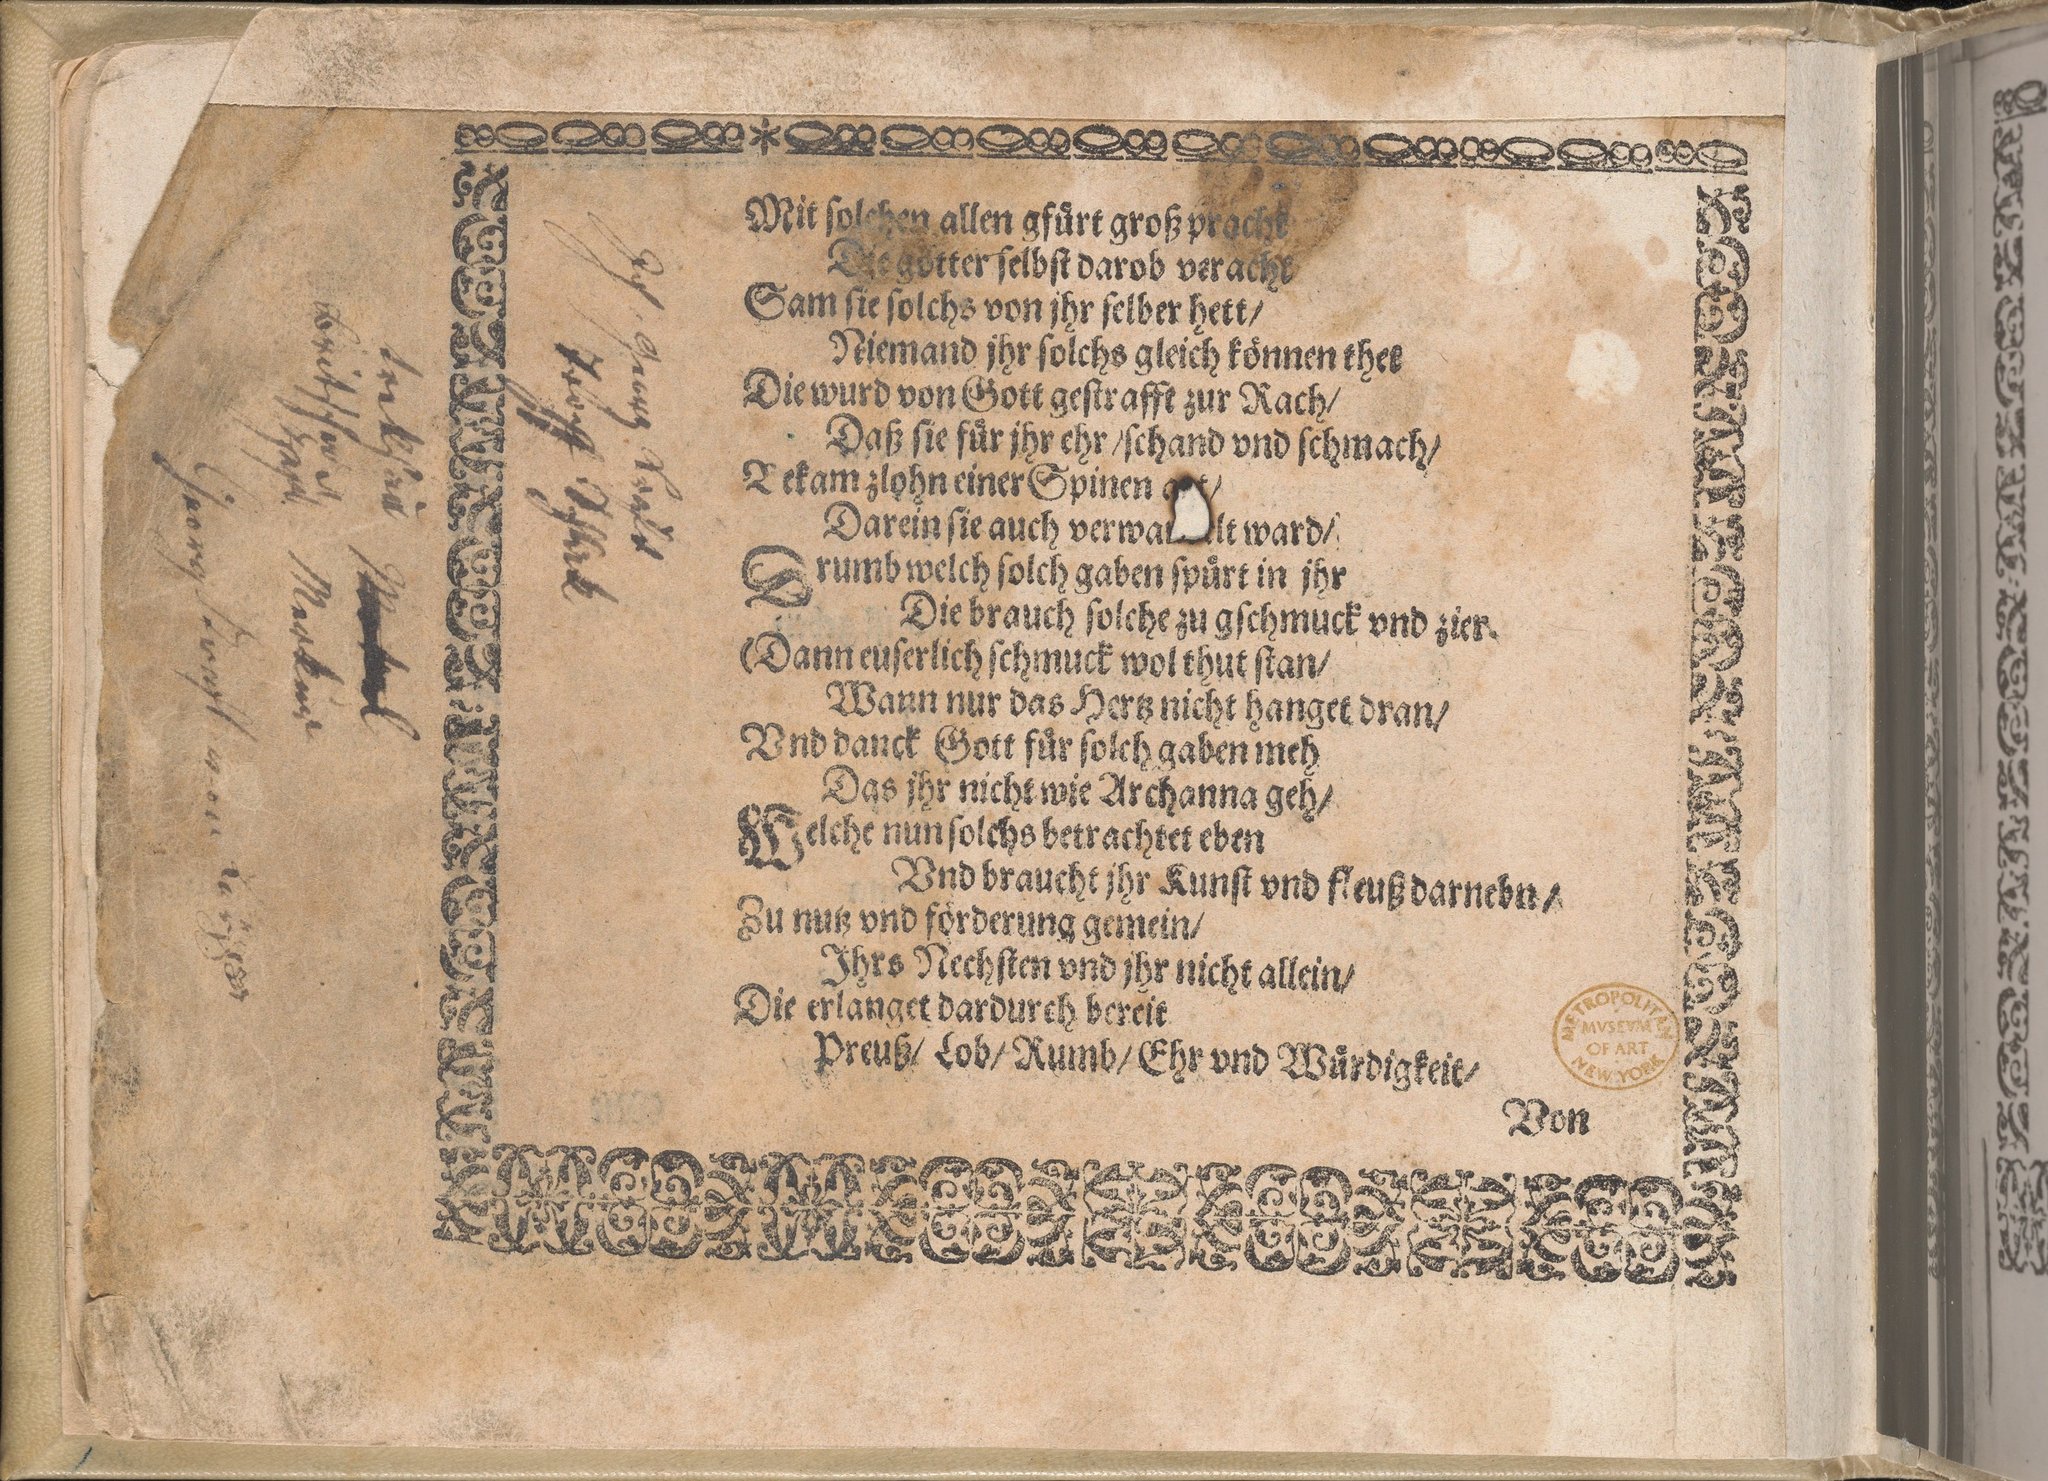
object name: book print ornament architecture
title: Schön Neues Modelbuch (Page 4 verso)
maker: johann sibmacher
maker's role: designer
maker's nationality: german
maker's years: 1590-1611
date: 1597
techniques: woodcut